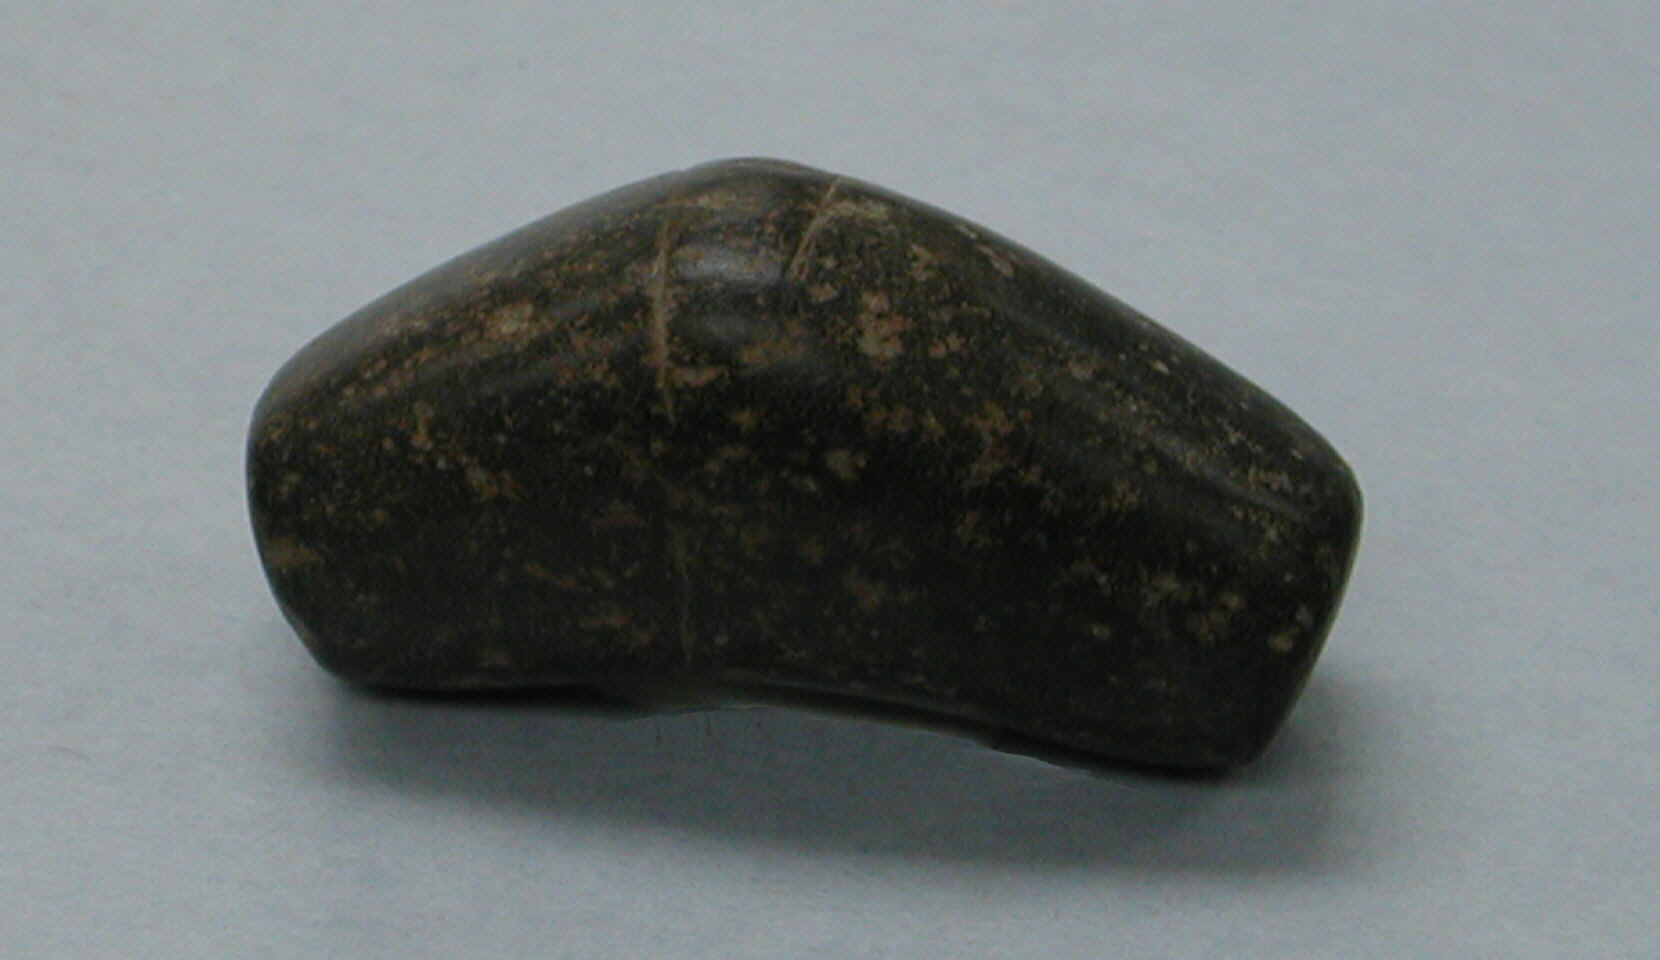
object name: ritual stone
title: Stone Pulidor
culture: mexican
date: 1501-1600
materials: stone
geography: mexico